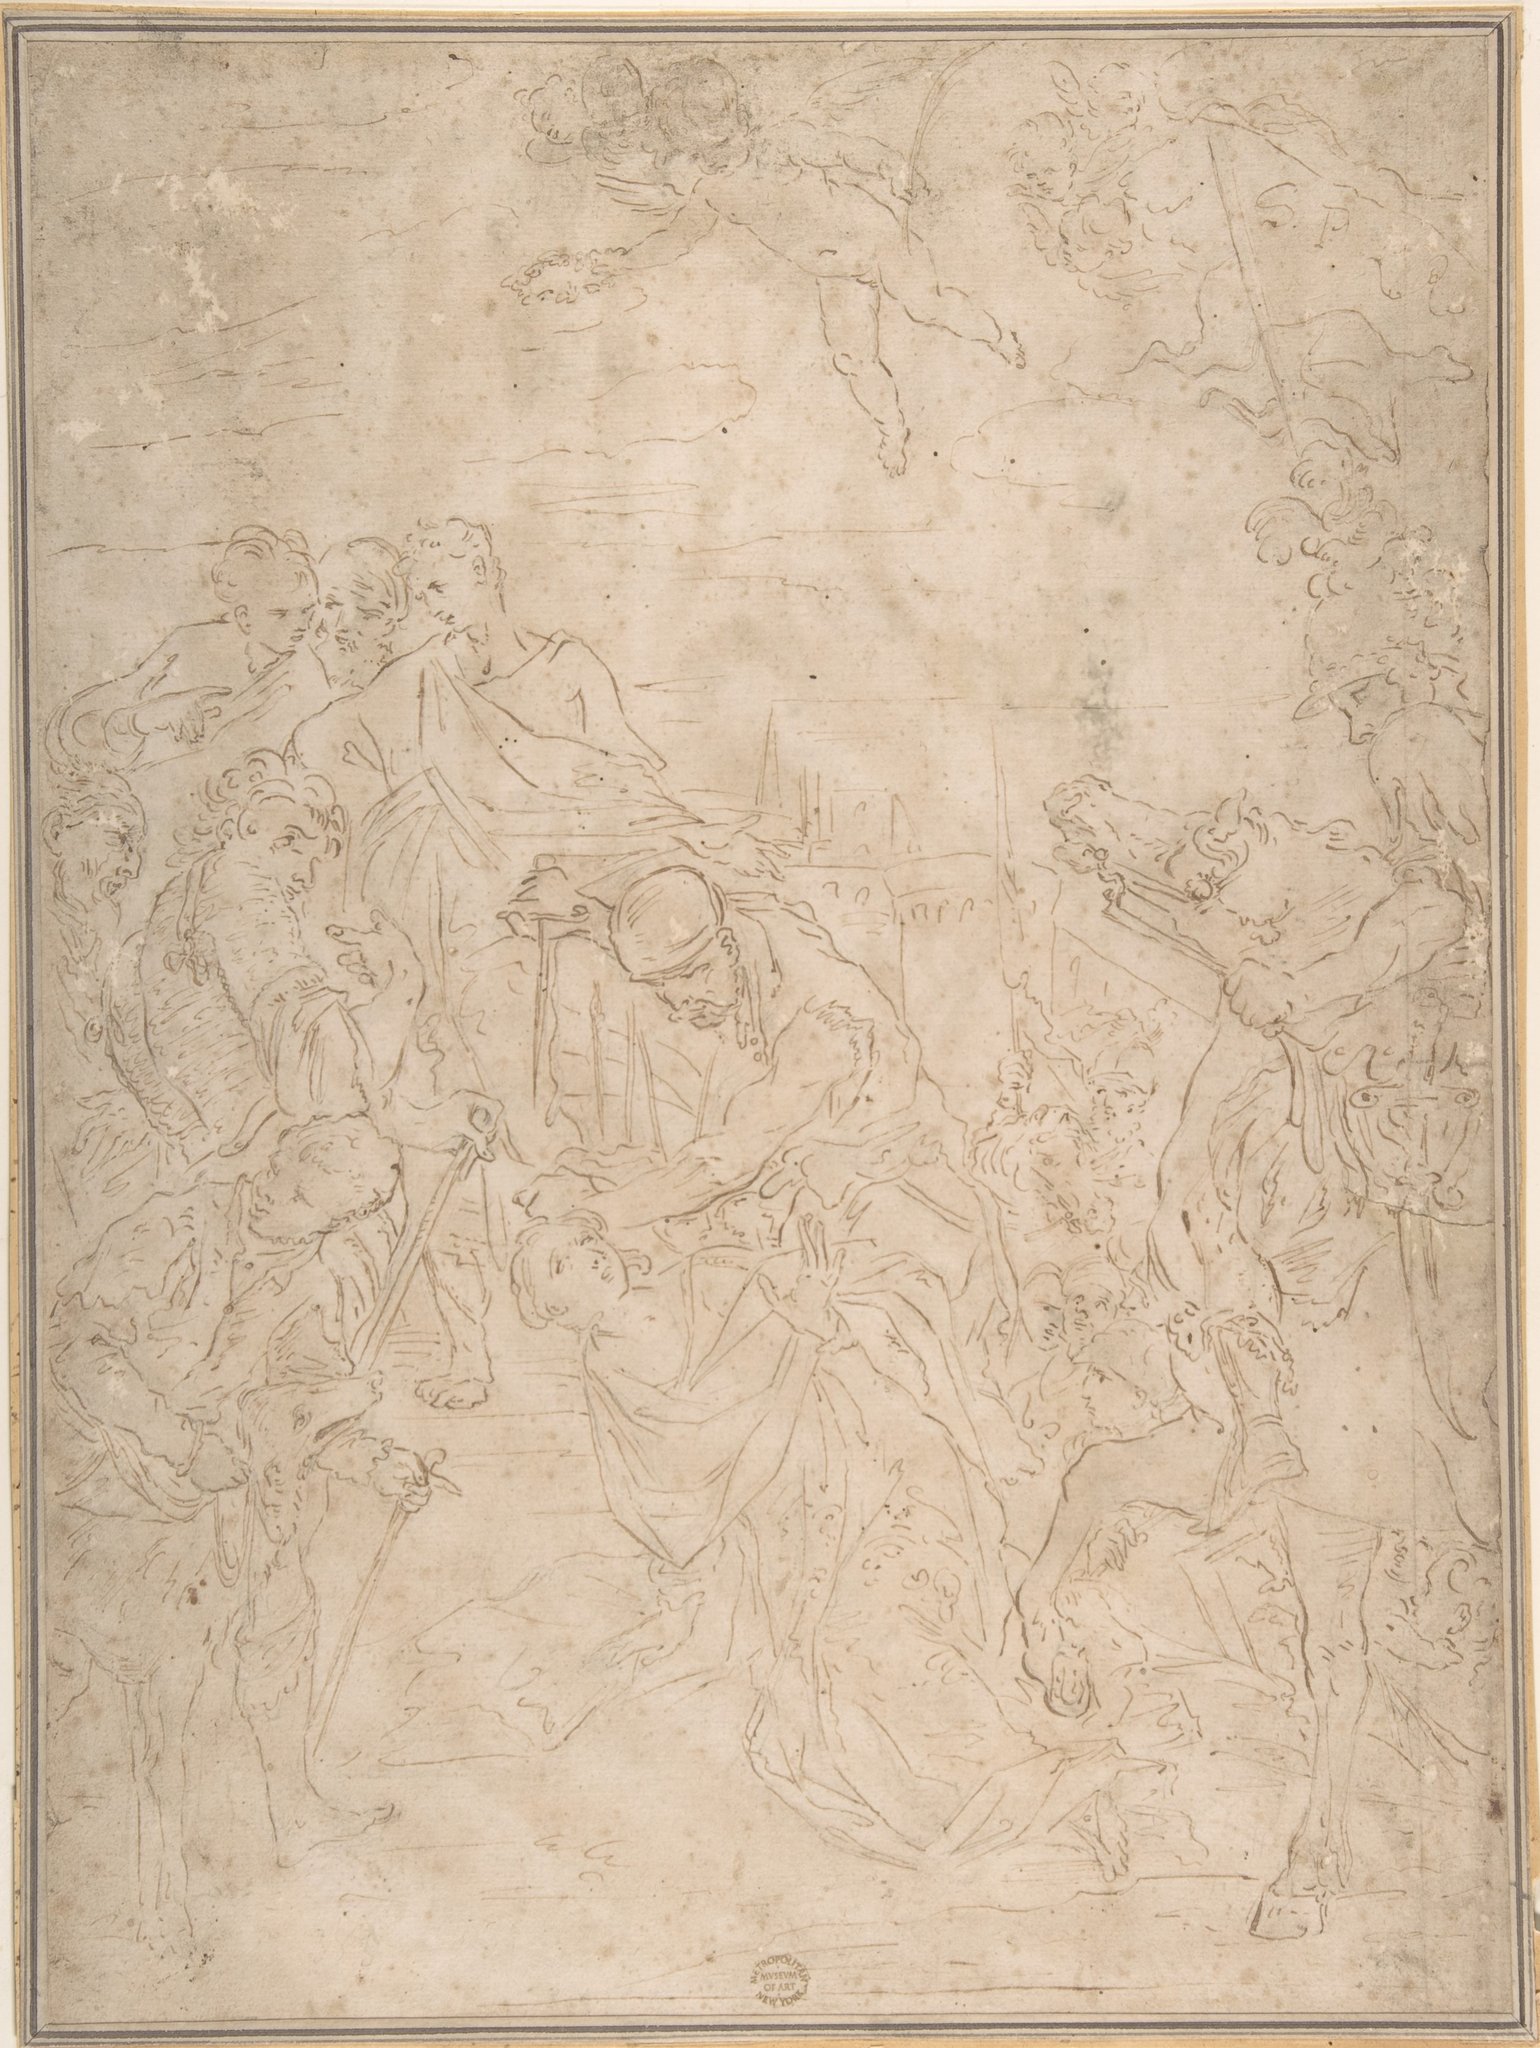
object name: drawing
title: Martyrdom of a Female Saint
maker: anonymous, italian, roman-bolognese, 17th century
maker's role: artist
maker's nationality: italian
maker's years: 1600-1700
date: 1601-1700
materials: chalk, ink, paper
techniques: pen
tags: suffering,men,women,angels,saints